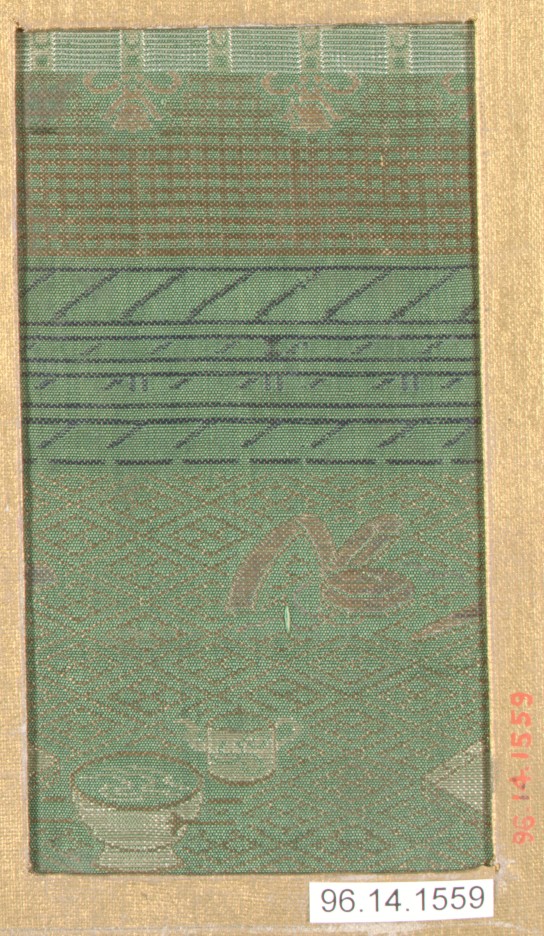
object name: piece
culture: japanese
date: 1701-1900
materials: silk